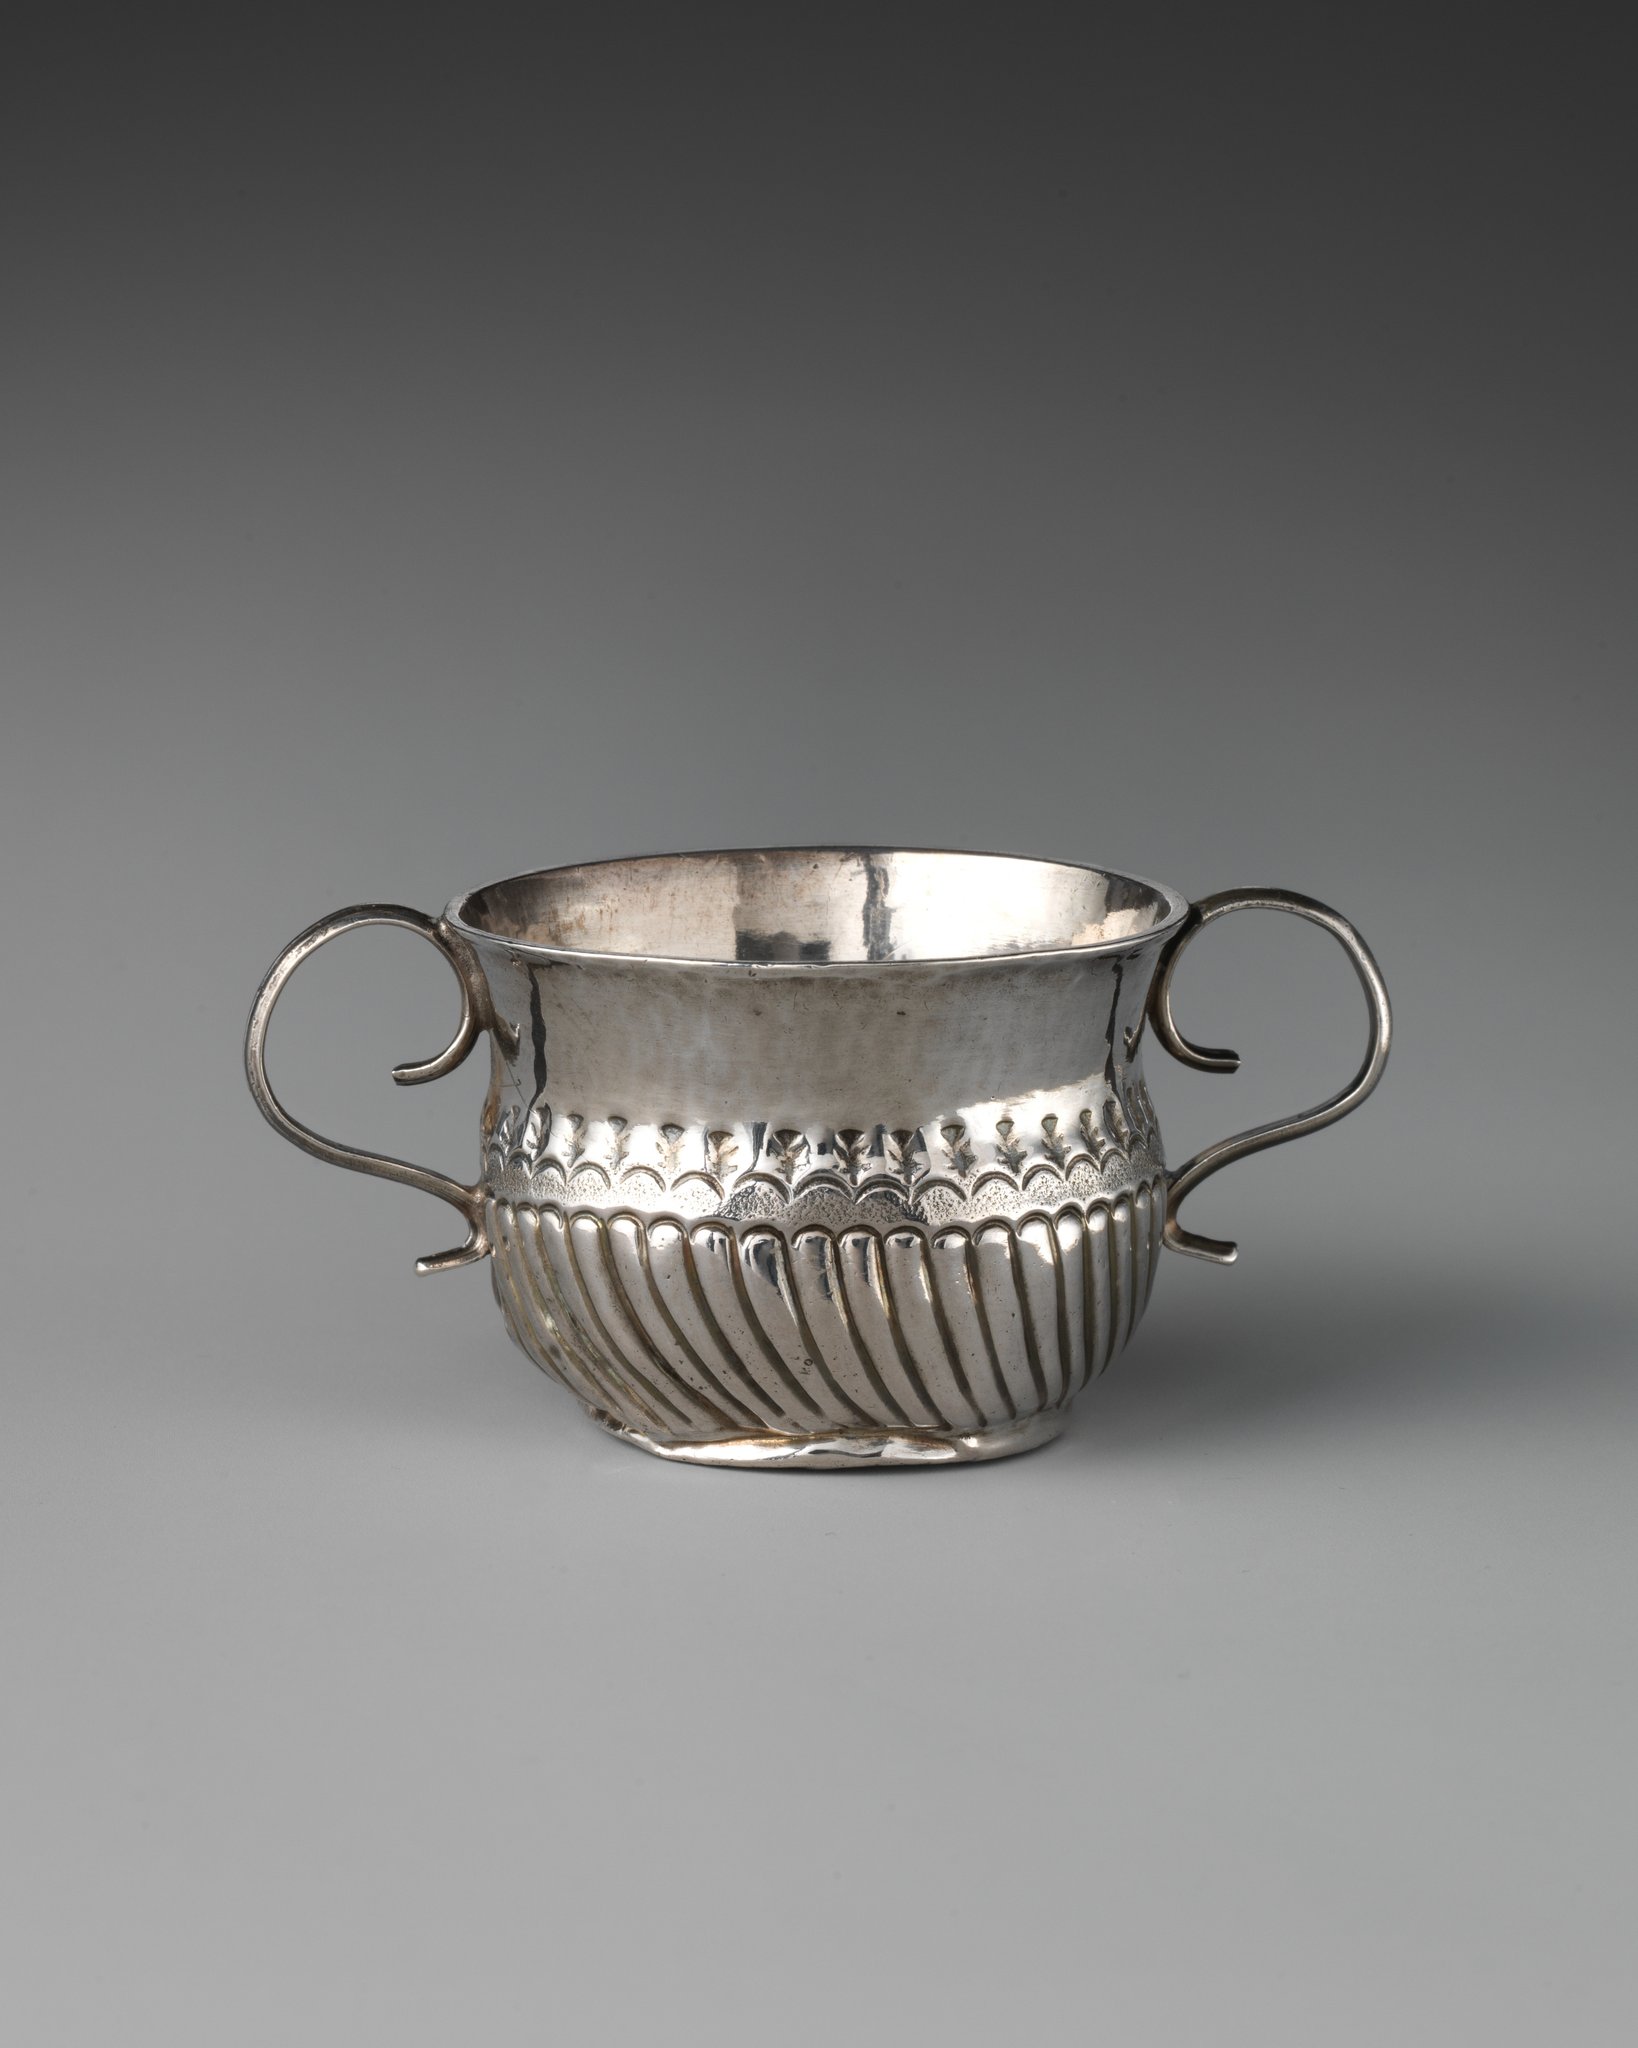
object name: cup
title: Miniature cup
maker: william fleming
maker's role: maker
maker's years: 1695-1727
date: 1714-1715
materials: silver